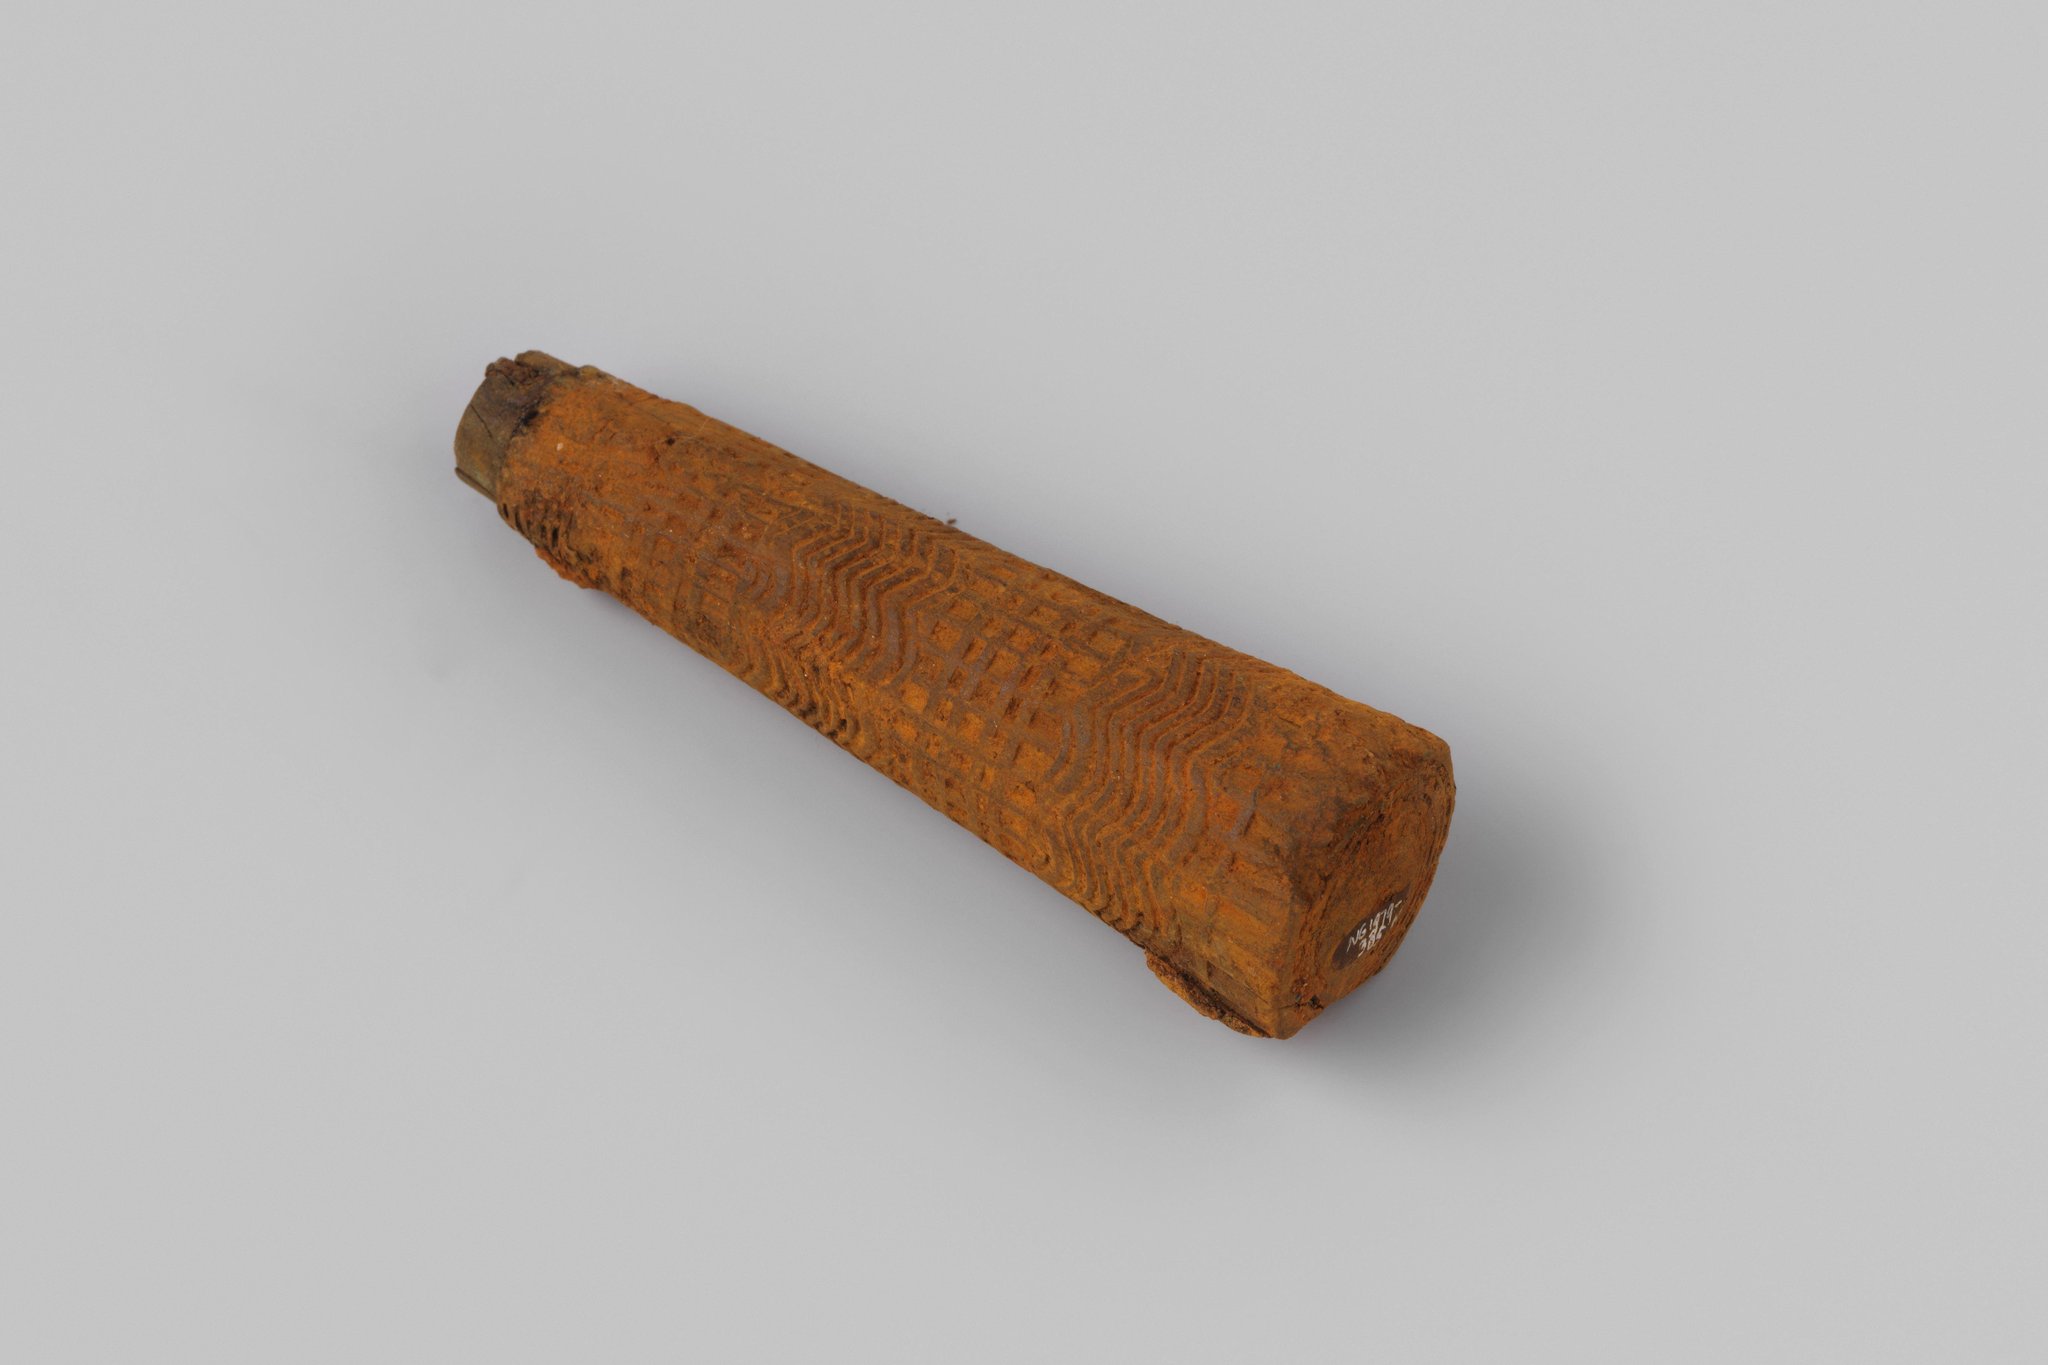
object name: knife handle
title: Messenheft uit het wrak van de Oost-Indiëvaarder Hollandia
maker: Anonymous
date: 1700-1743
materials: wood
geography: netherlands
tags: verenigde oostindische compagnie, hollandia (schip), annet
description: Knife, handle, cylindrical: tapering; id. NG 1979-403H, ferrules id. NG 1980-27H426.